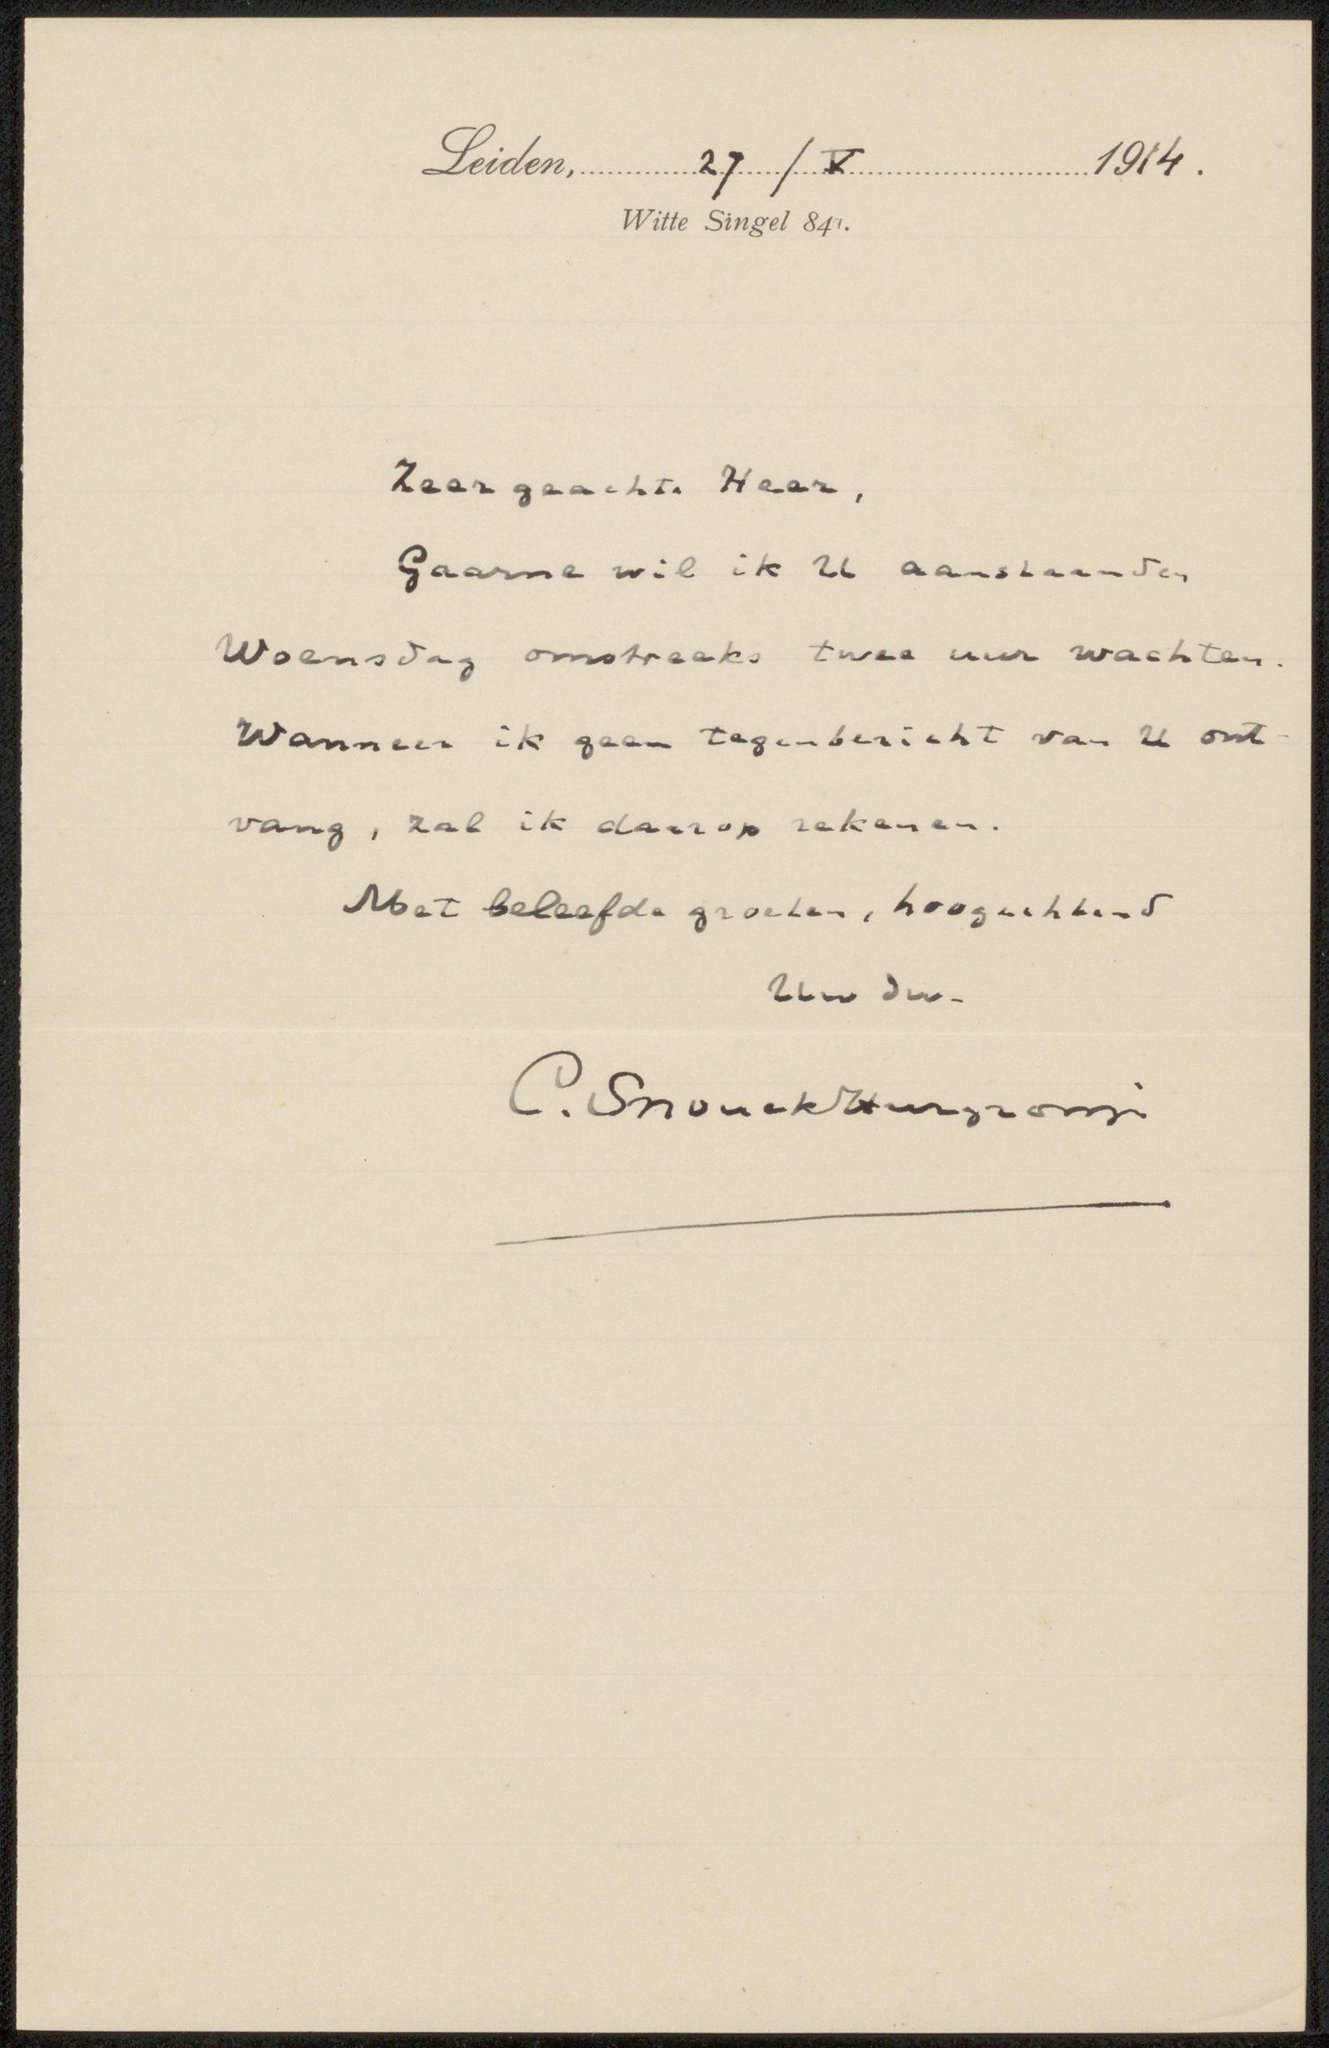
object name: letter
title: Brief aan Philip Zilcken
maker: christiaan snouck hurgronje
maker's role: fotograaf, schrijver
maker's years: 1857-1936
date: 1914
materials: ink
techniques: pen, printing, writing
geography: leiden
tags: painter, draughtsman, philip zilcken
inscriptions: collector's mark: ‘RPK’